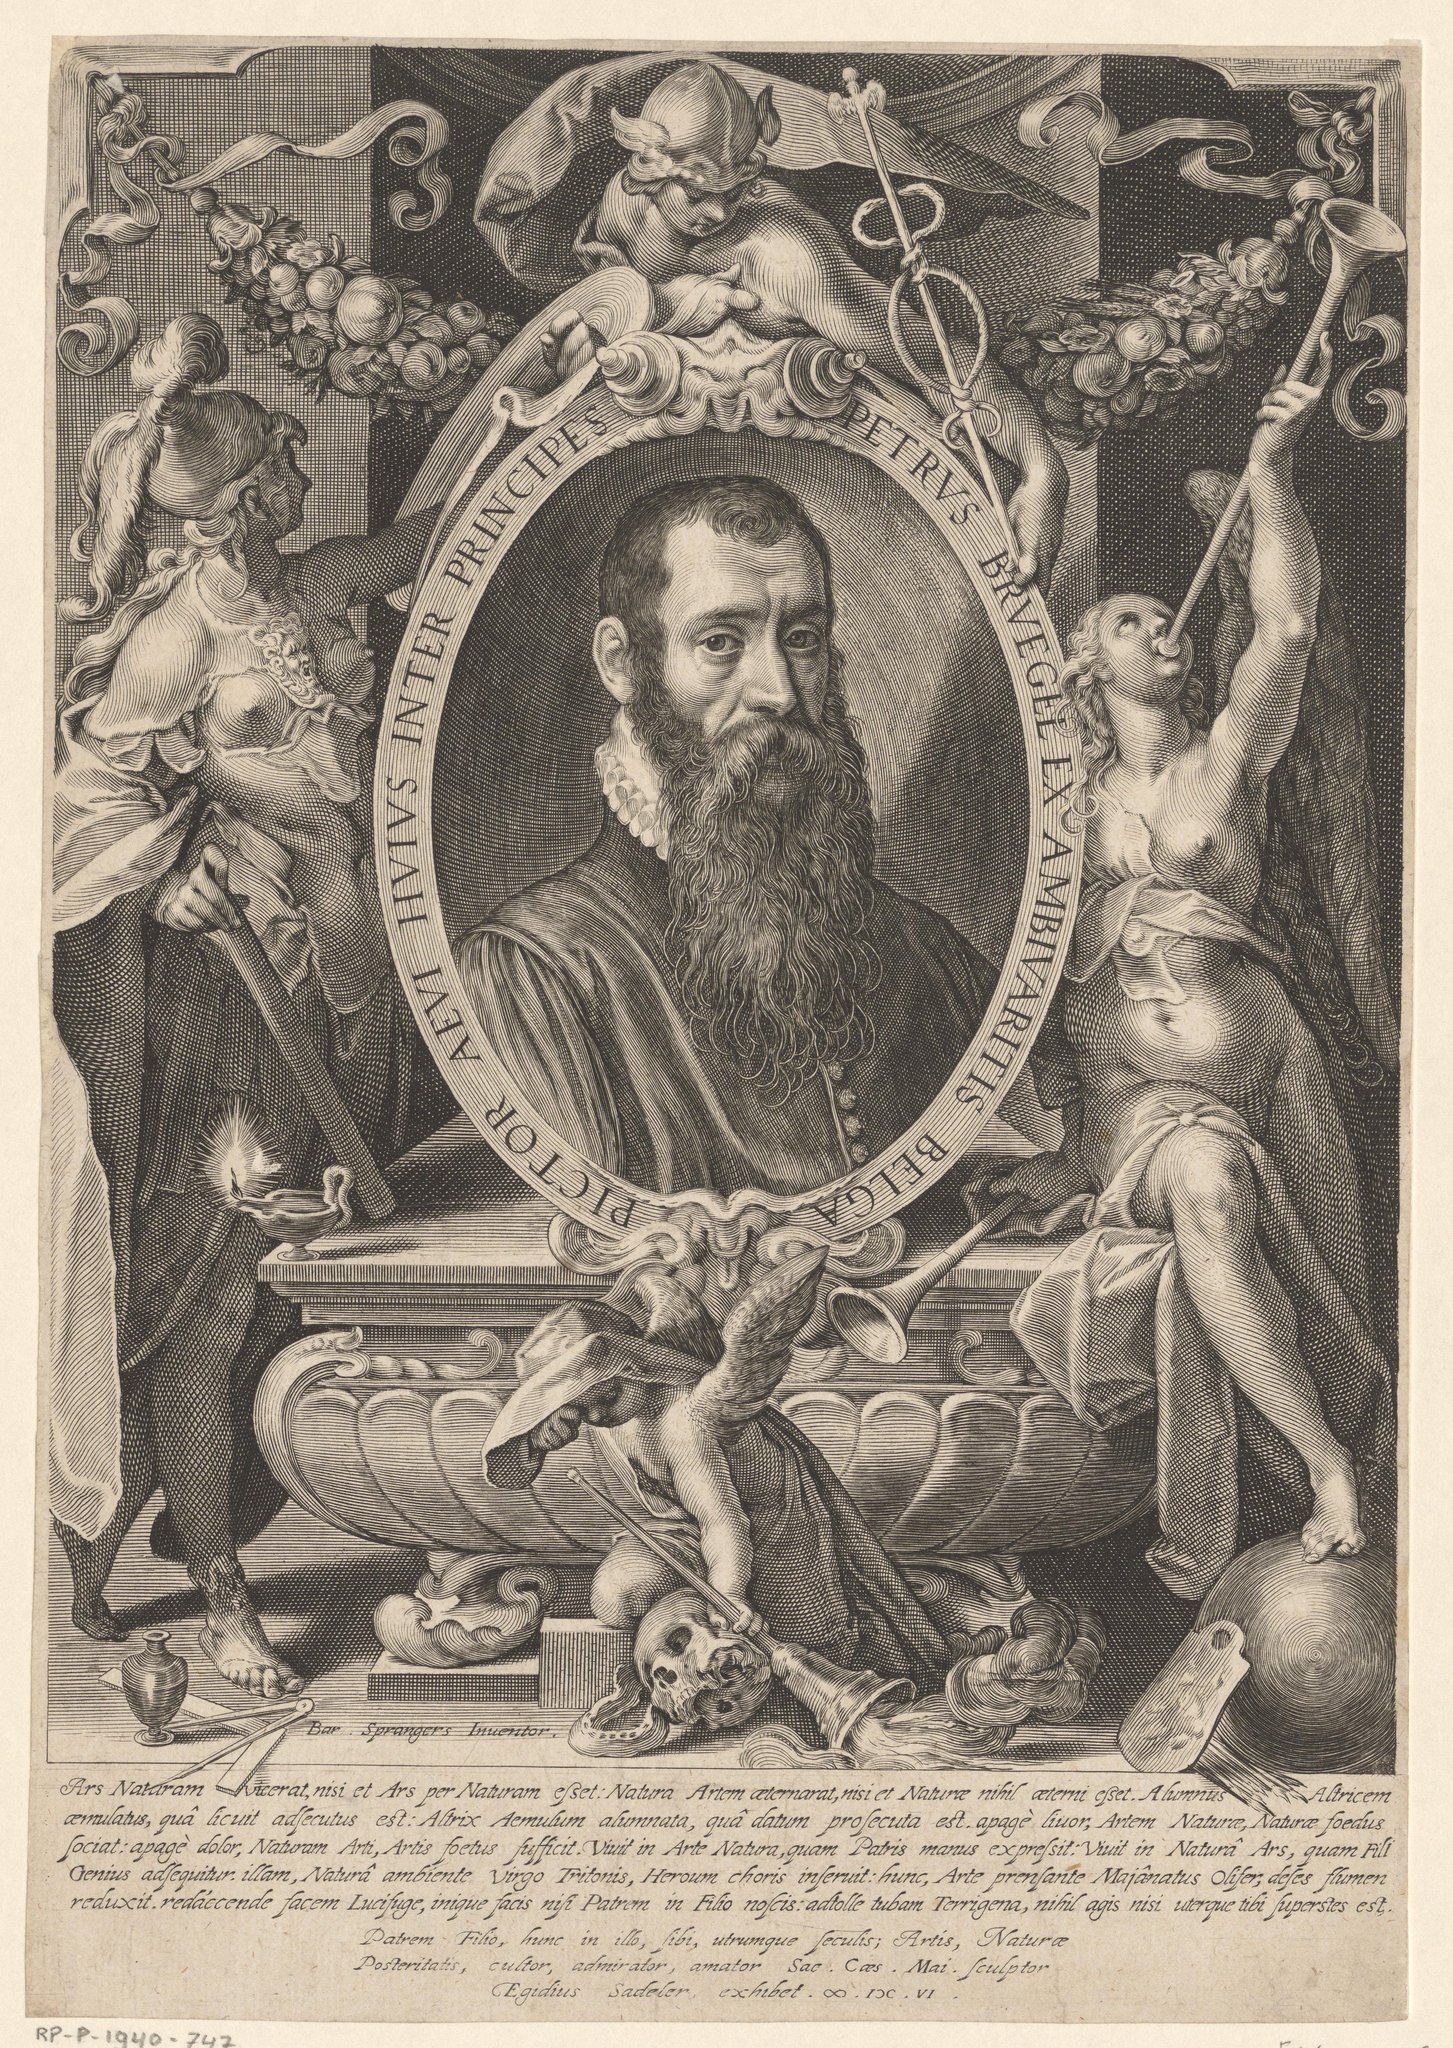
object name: print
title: Portret van Pieter Bruegel (I)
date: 1606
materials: paper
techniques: engraving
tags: print maker, draughtsman, pieter bruegel (i), (story of) minerva (pallas, athena), (story of) mercury (hermes), historical persons, portrait, self-portrait of artist, fame; 'fama', 'fama buona', 'fama chiara' (ripa)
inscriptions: collector's mark: Lugt 2228, collector's mark: Lugt 2760